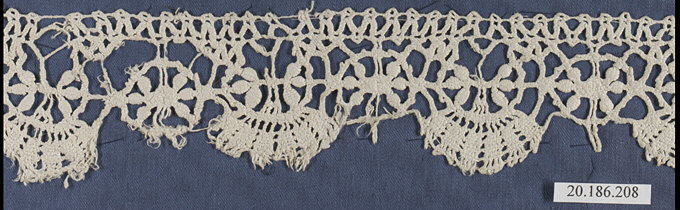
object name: edging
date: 1601-1700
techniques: lace